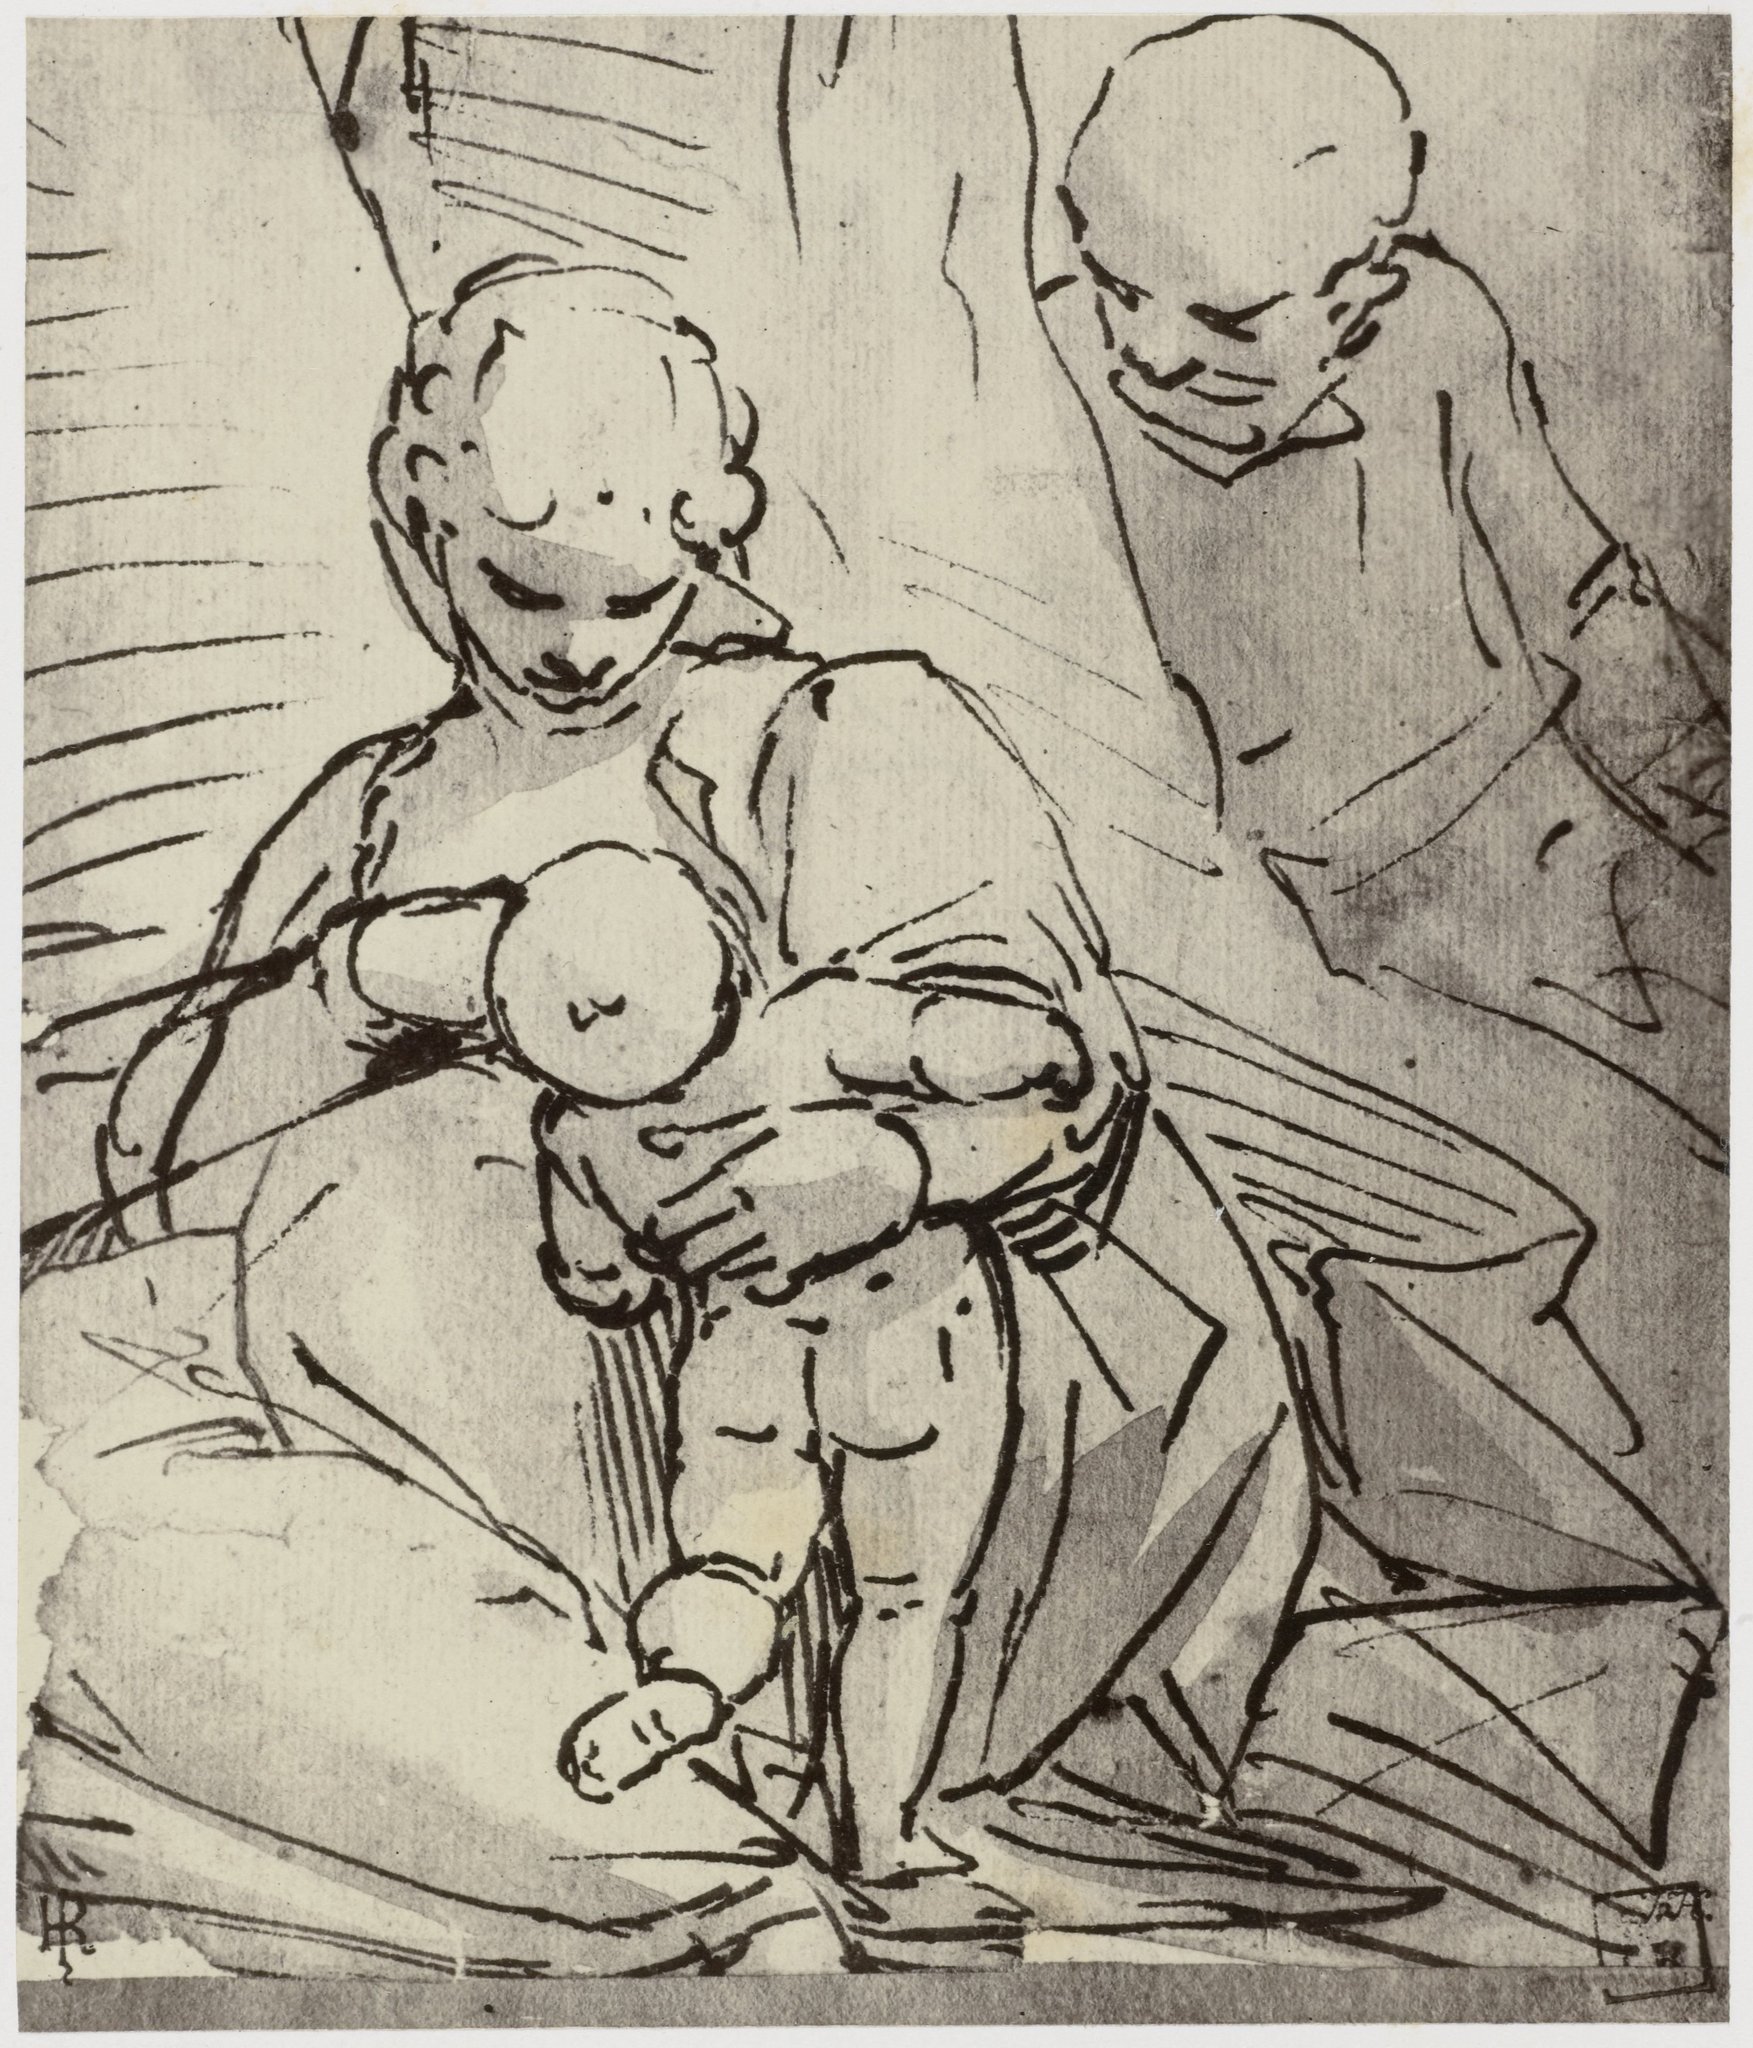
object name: photograph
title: Cangiasi, Holy Family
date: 1855-1858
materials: cardboard, paper, photographic support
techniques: albumen print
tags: drawing, sketch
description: Fotoreproductie van tekening in 'The Reveley Collection of Drawings at Brynygwin', afb. 32.